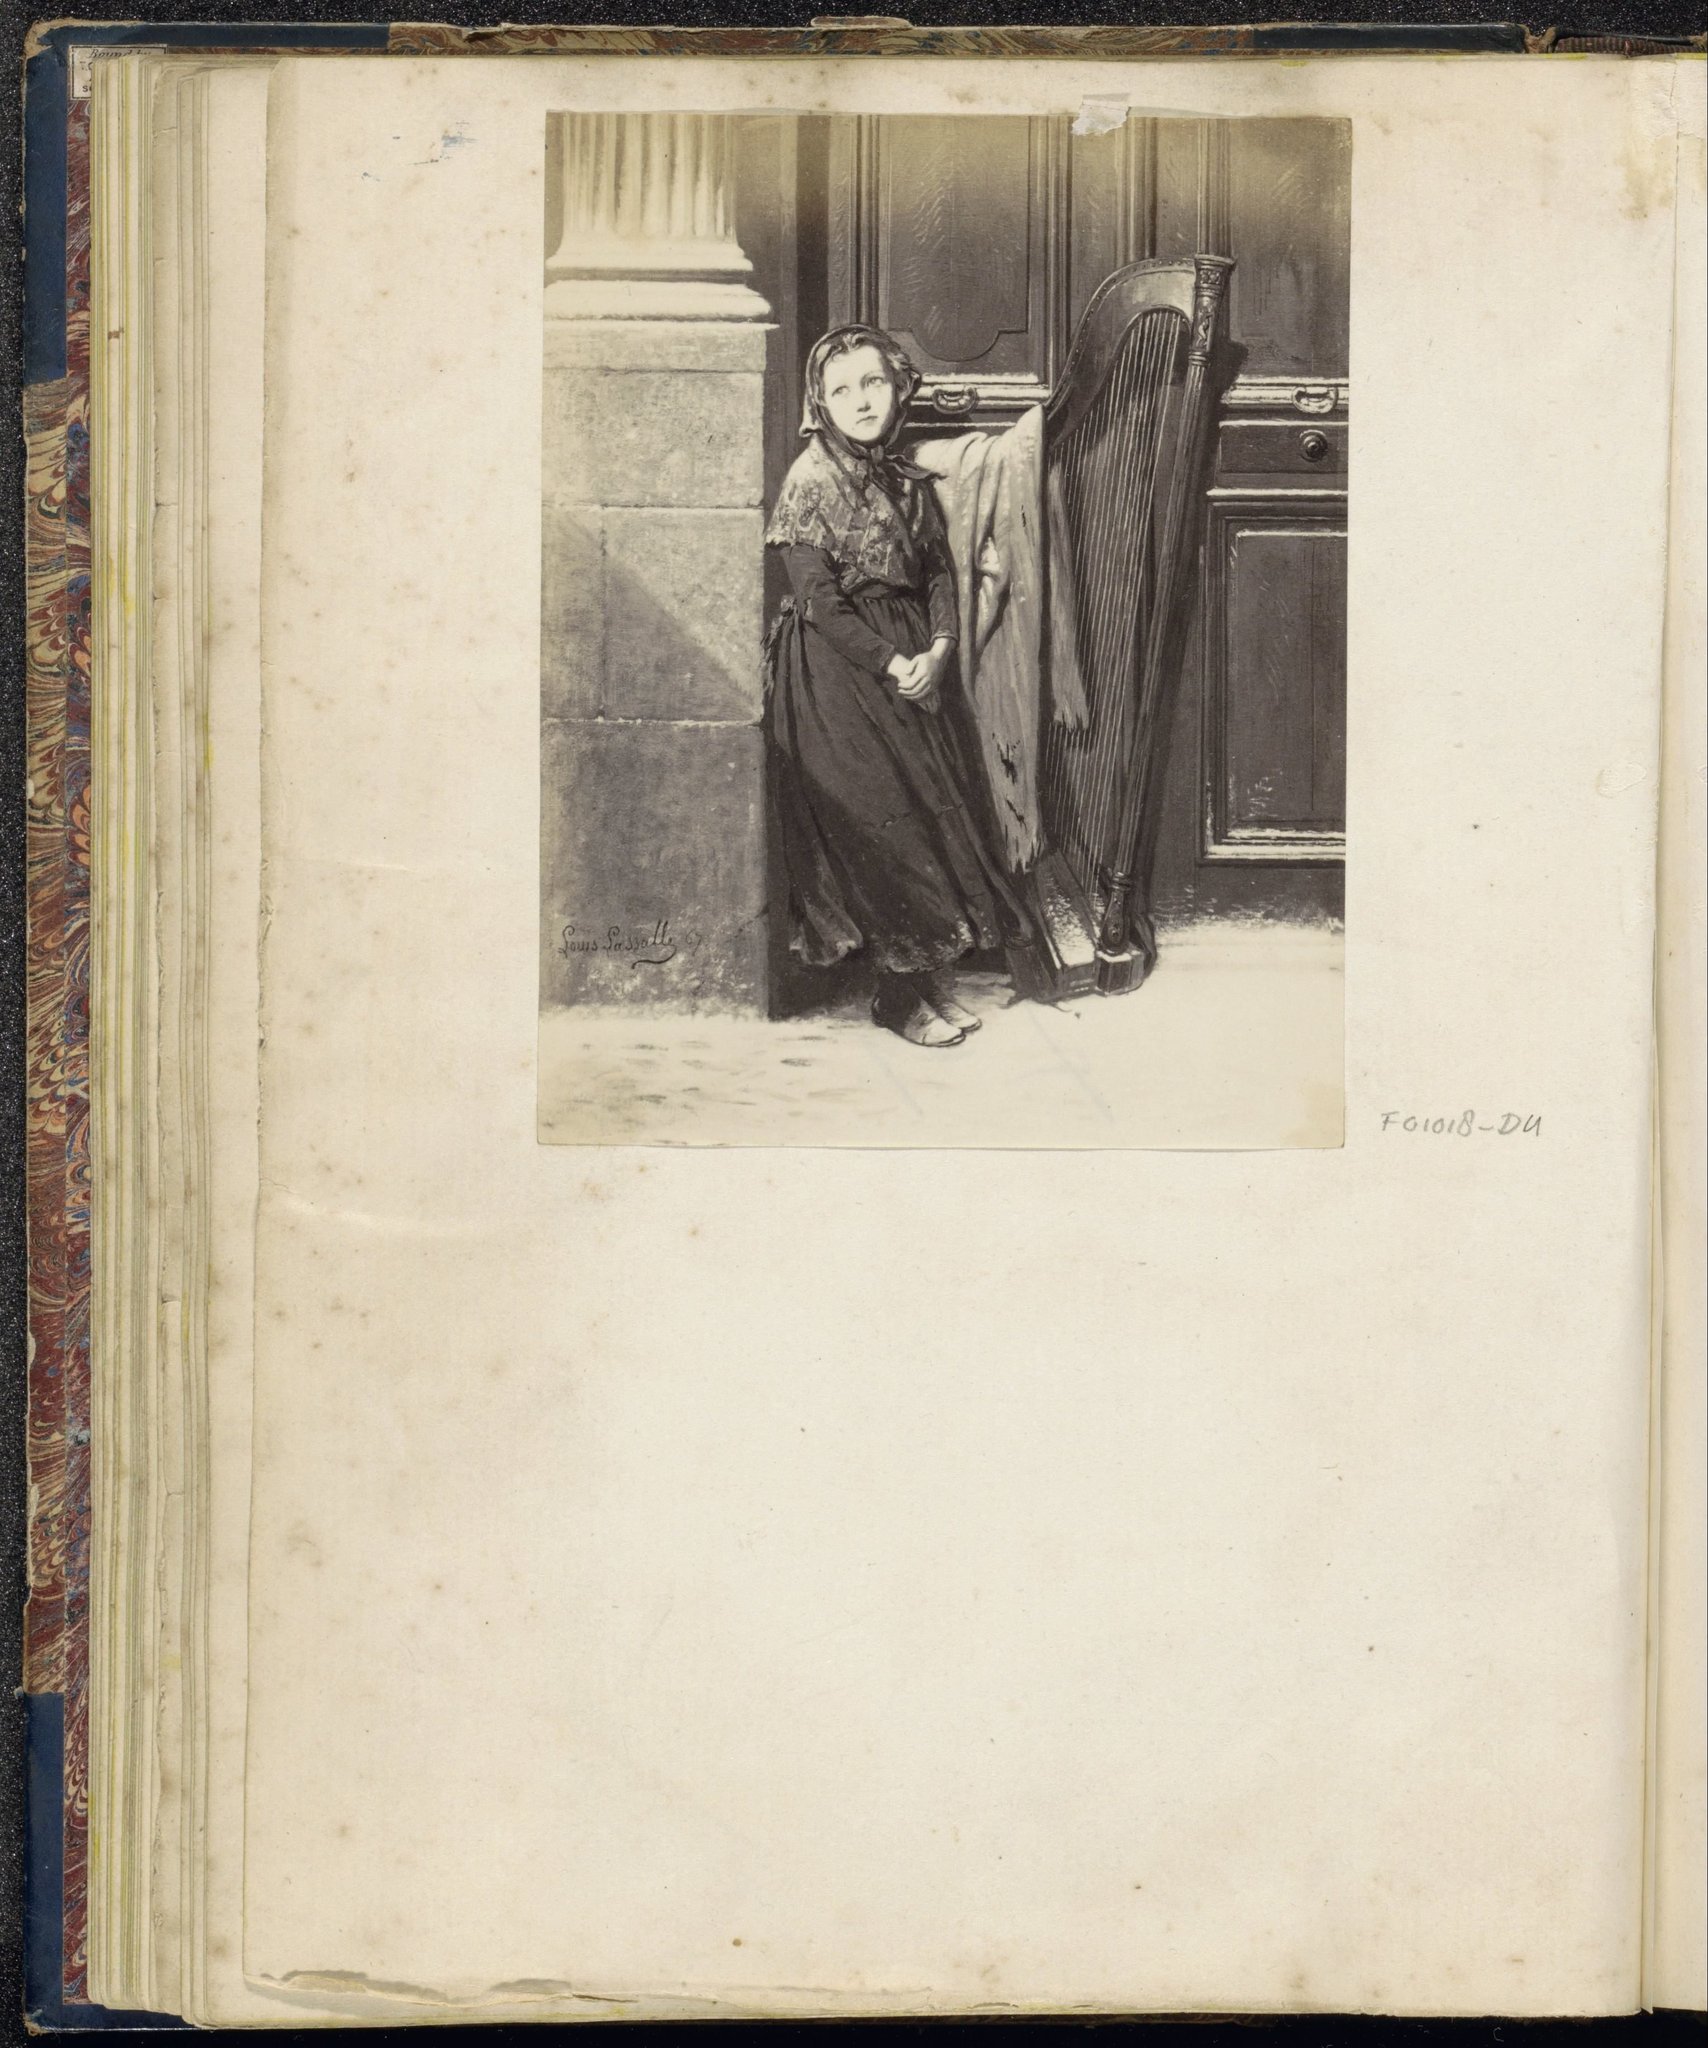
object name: photograph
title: Fotoreproductie van een schilderij van Louis Lasalle voorstellend een jong meisje naast een harp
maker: Anonymous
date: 1867-1870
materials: paper, photographic support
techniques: albumen print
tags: coldness, child, harp, snow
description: Onderdeel van Engels familiealbum met foto's van personen, reizen, cricket en kunstwerken.